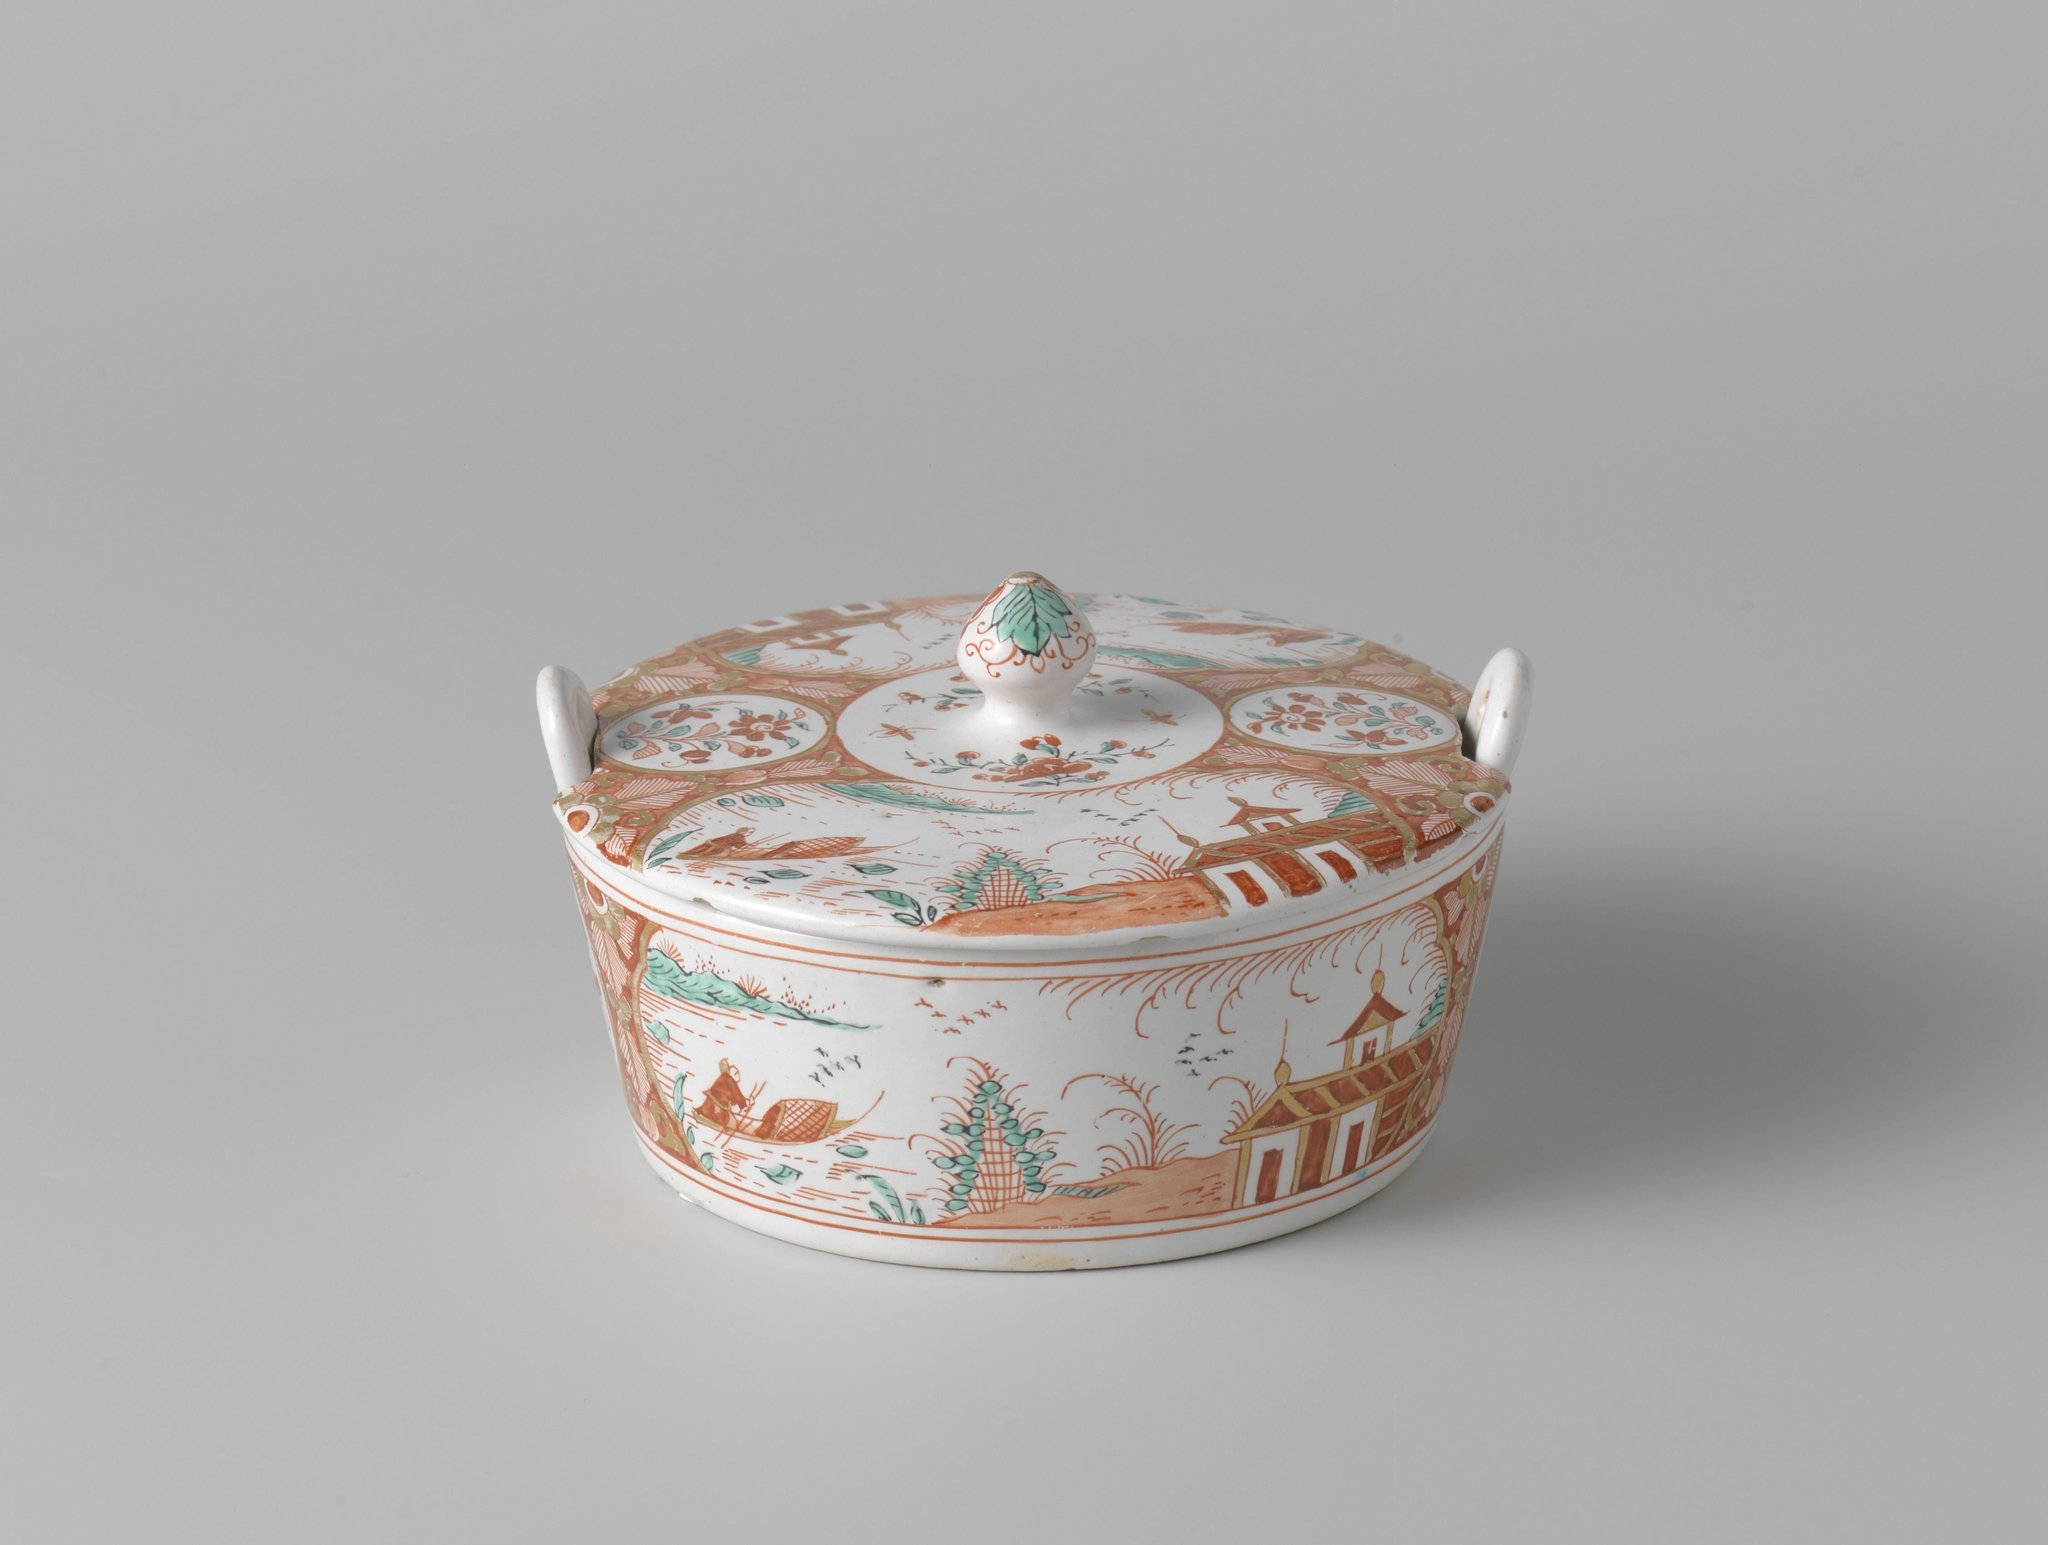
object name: butter dish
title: Botervloot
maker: Anonymous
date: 1740-1765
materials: faience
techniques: kiln, painted, polychromy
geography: delft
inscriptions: collector's mark: ‘koninklijk oudheidkundig genootschap no. 20’, inscription: ‘4’, mark: ‘VA’, inscription: ‘80’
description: Botervloot met opstaande oortjes veelkleurig beschilderd met een oosters landschap met gebouwen binnen cartouches.